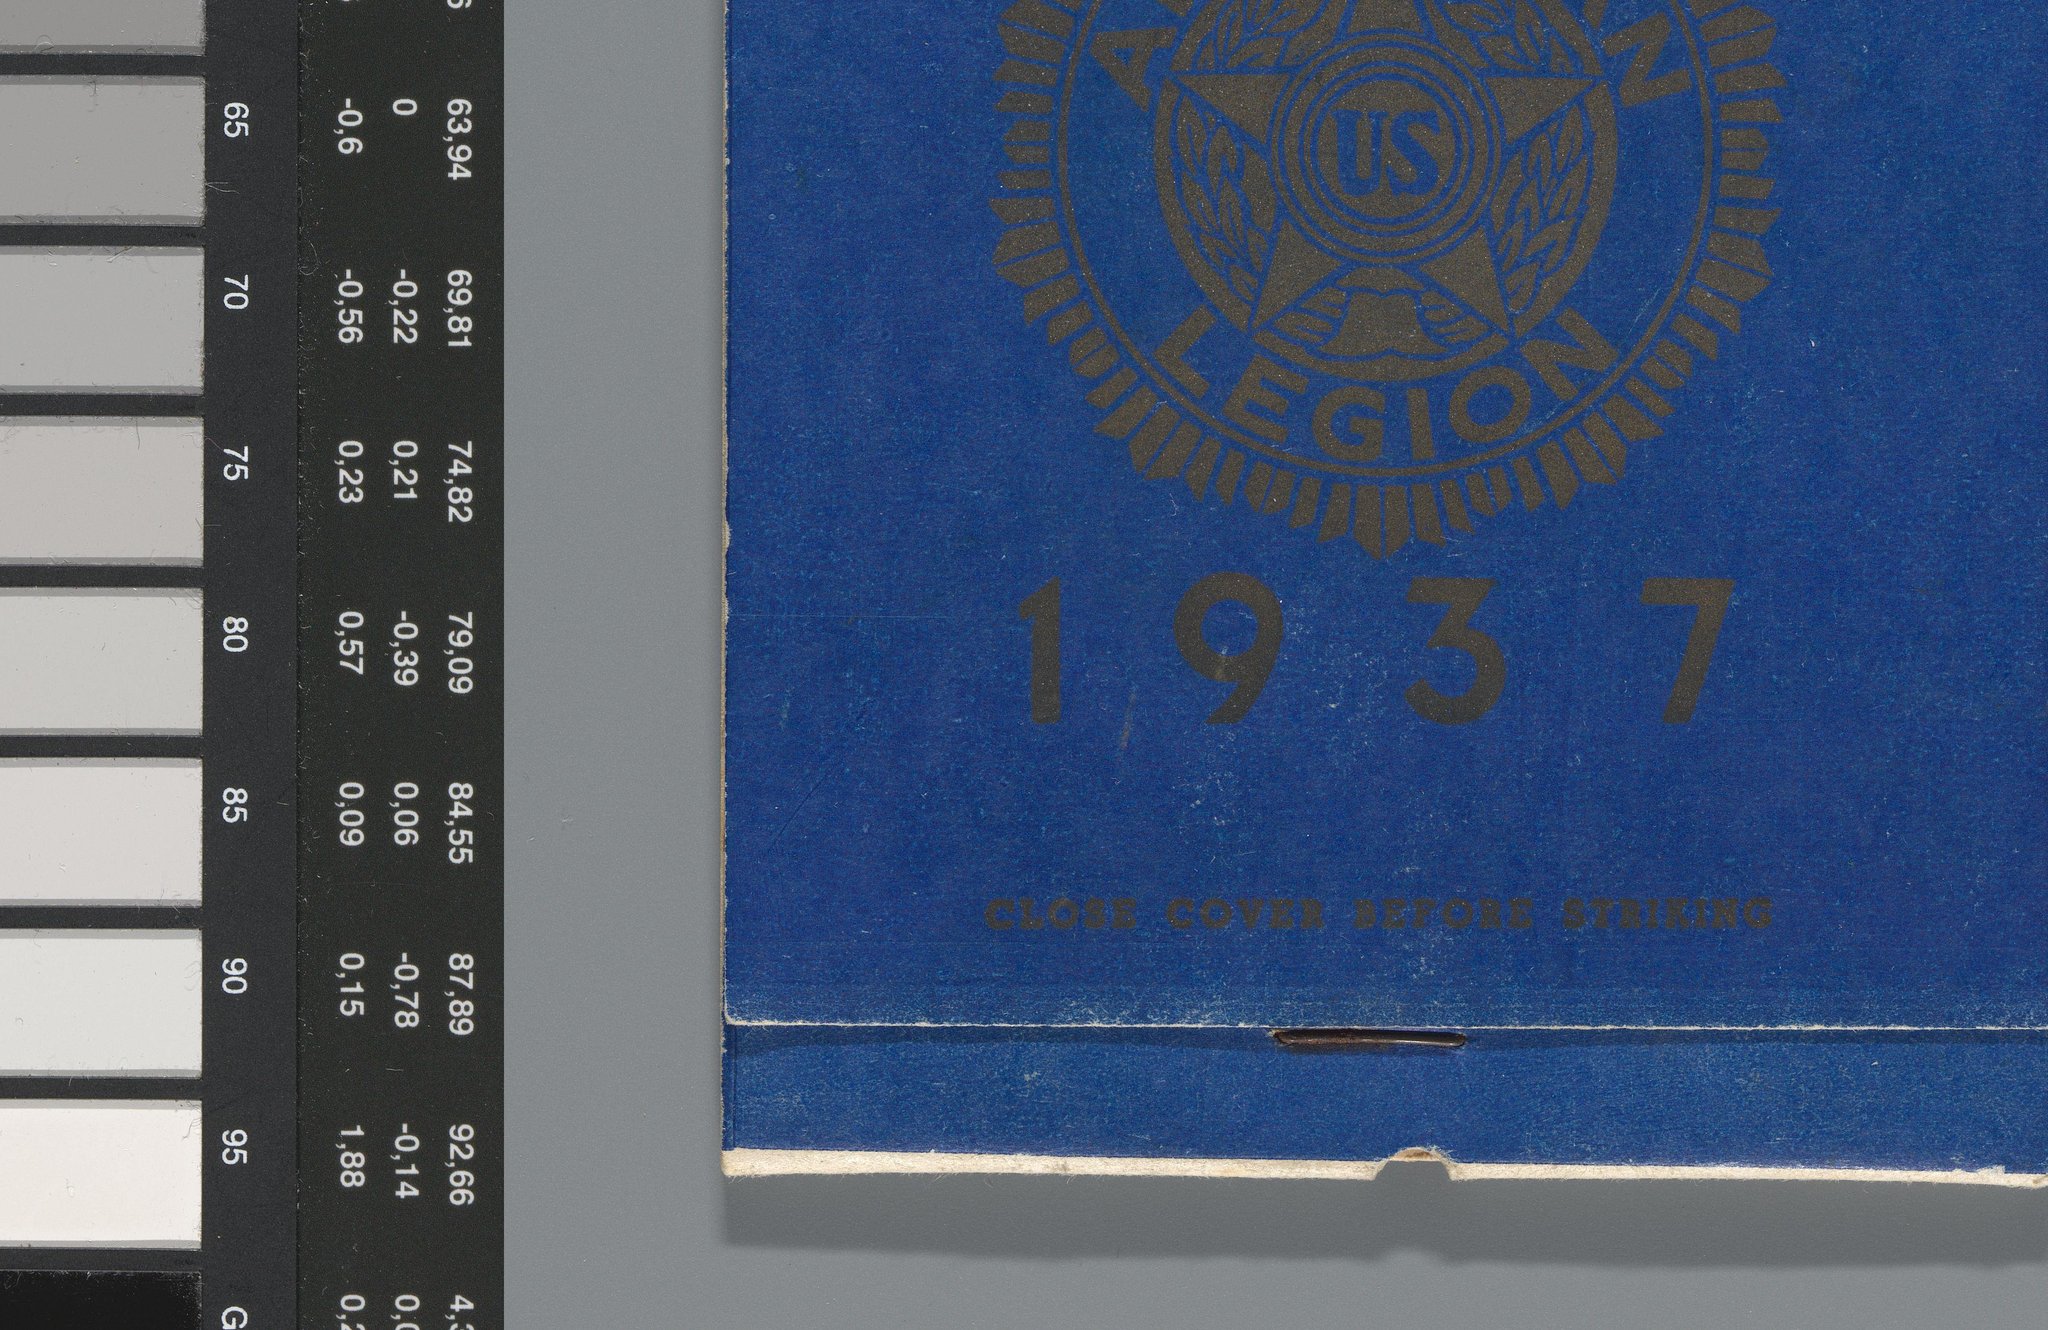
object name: photograph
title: Luciferboekje met foto van een parade van de American Legion op de lucifers gedrukt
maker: Anonymous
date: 1937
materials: paper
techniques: autotype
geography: united states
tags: new york (city)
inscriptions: inscription: ‘GIANT “FEATURE” MATCH BOOKS / REG. U.S. PAT. OFF. / MADE UNDER ONE OR MORE OF THE FOLLOWING PATENTS: / […] / LION MATCH CO., INC. N.Y.C. […]’, inscription: ‘UP FIFTH AVENUE AGAIN IN 1937!’, inscription: ‘LEGIONNAIRE IS AT HOTEL [LEEGGELA TEN] ROOM No. [LEEGGELATEN]’, inscription: ‘NEW YORK / 1937 / US / AMERICAN / LEGION / CKLOSE COVER BEFORE STRIKING // “UP FIFTH AVENUE AGAIN IN 1937!’